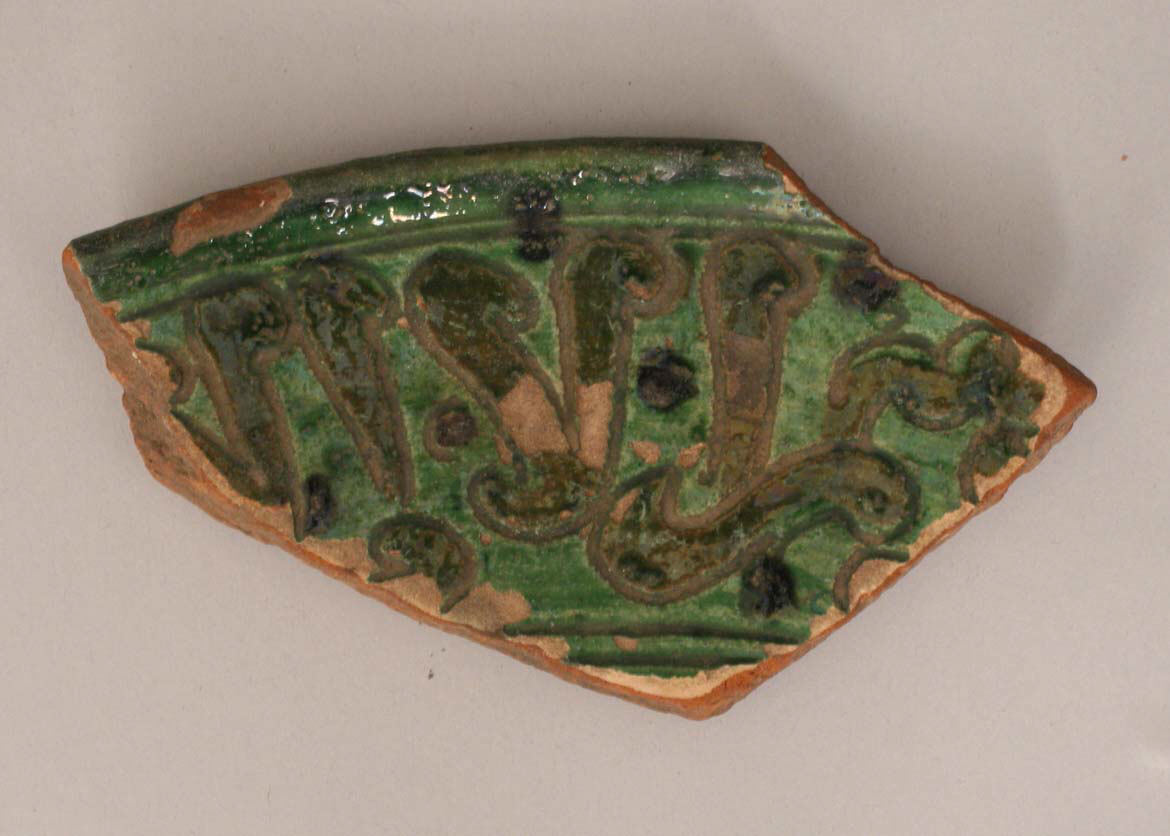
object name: fragment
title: Ceramic Fragment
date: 1301-1500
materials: earthenware, glaze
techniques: coloring, incising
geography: egypt